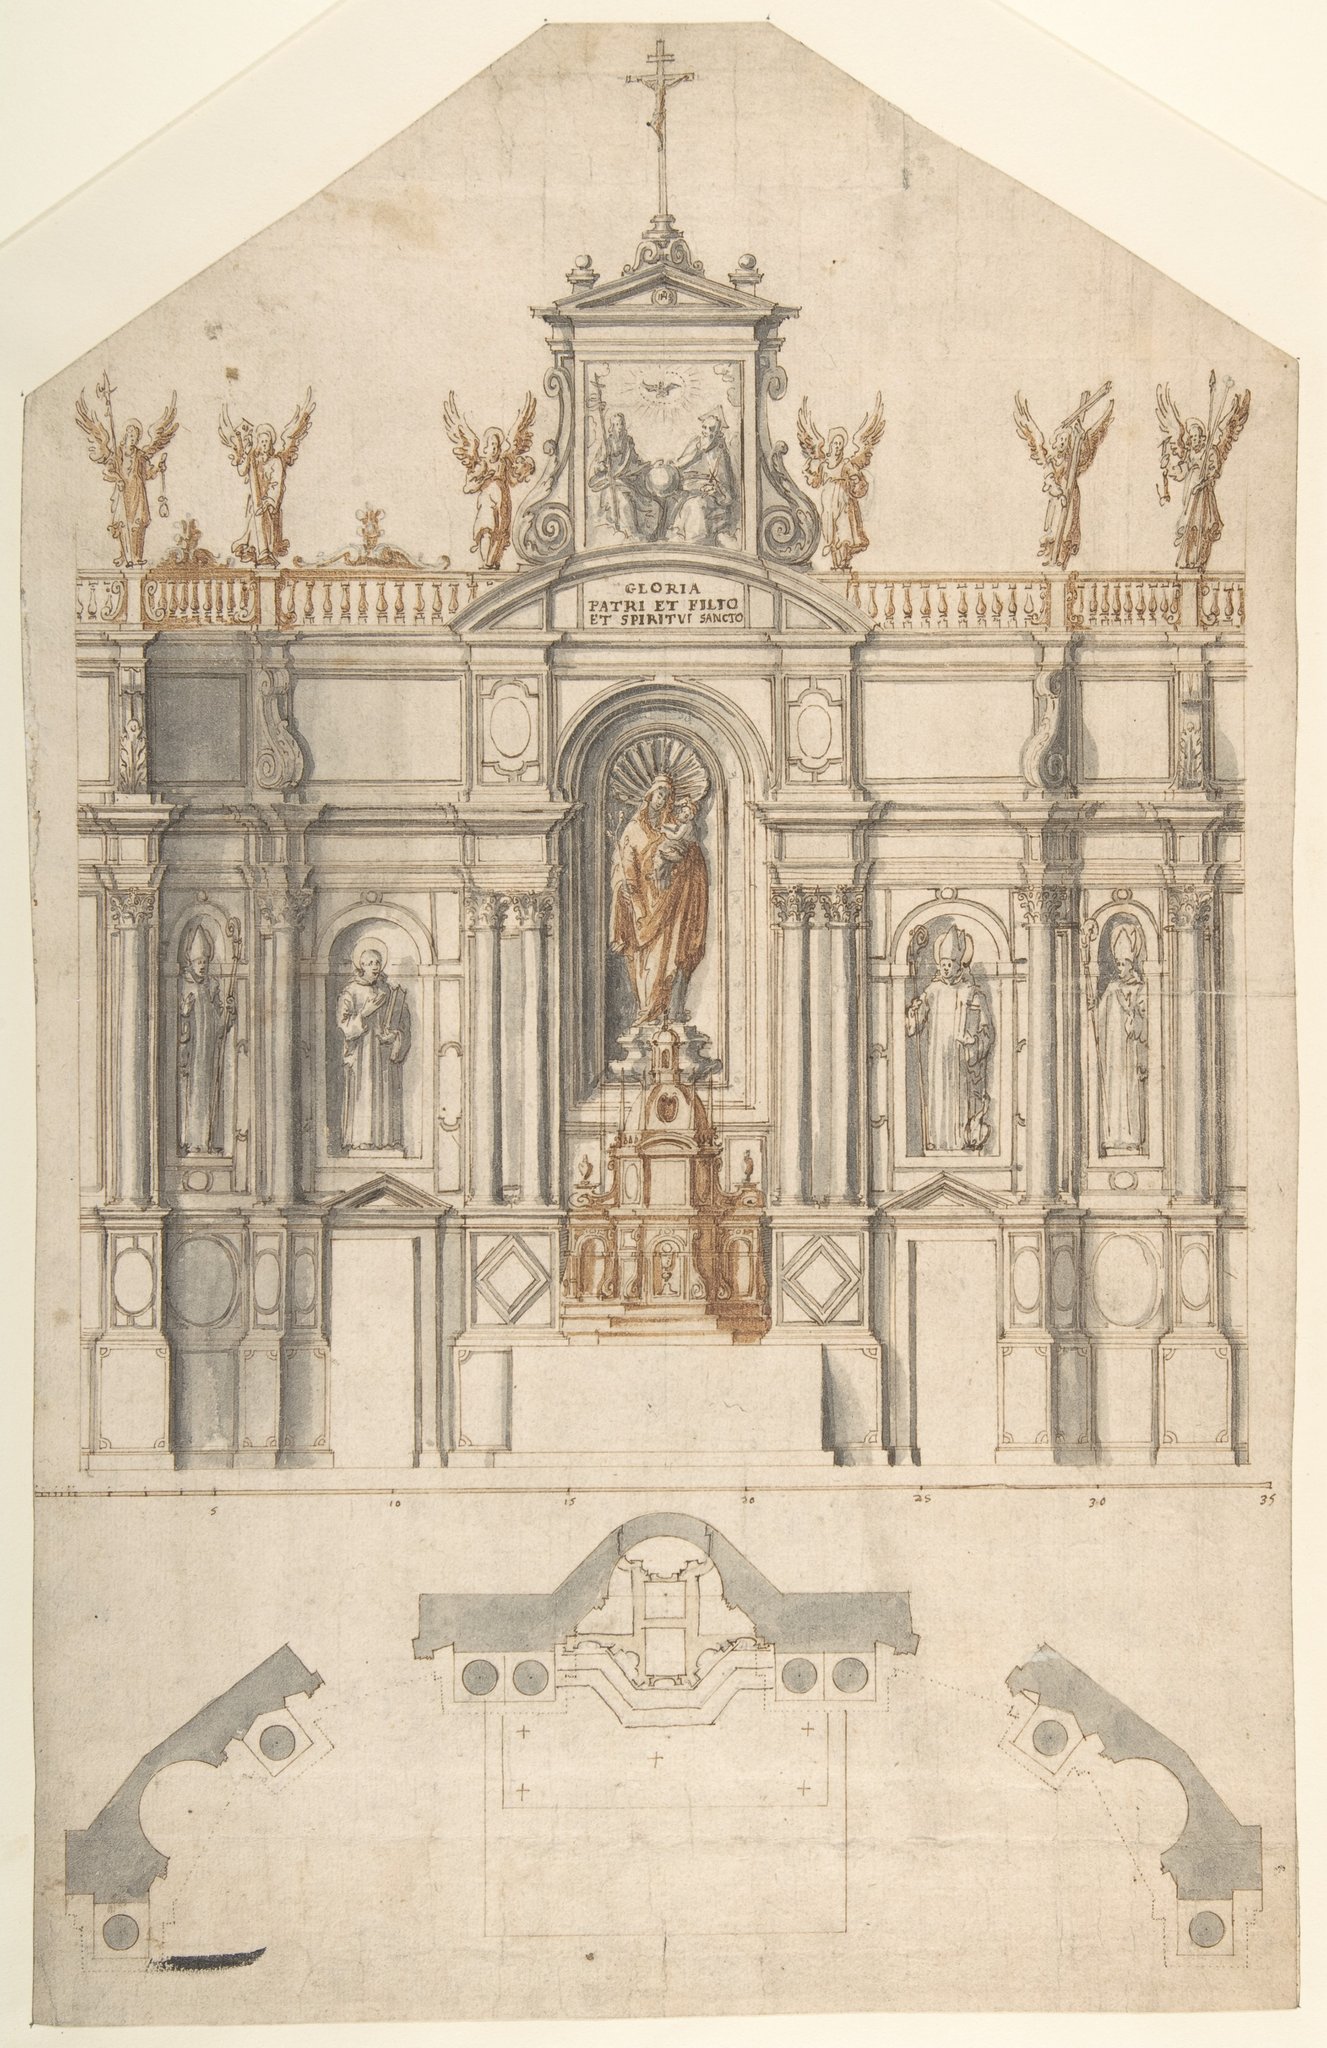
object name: drawing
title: Design for the Elevation and Plan of a Reredos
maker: anonymous, italian, north or central italy, 16th century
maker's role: artist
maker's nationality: italian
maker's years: 1500-1600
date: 1570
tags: angels,madonna and child,saints